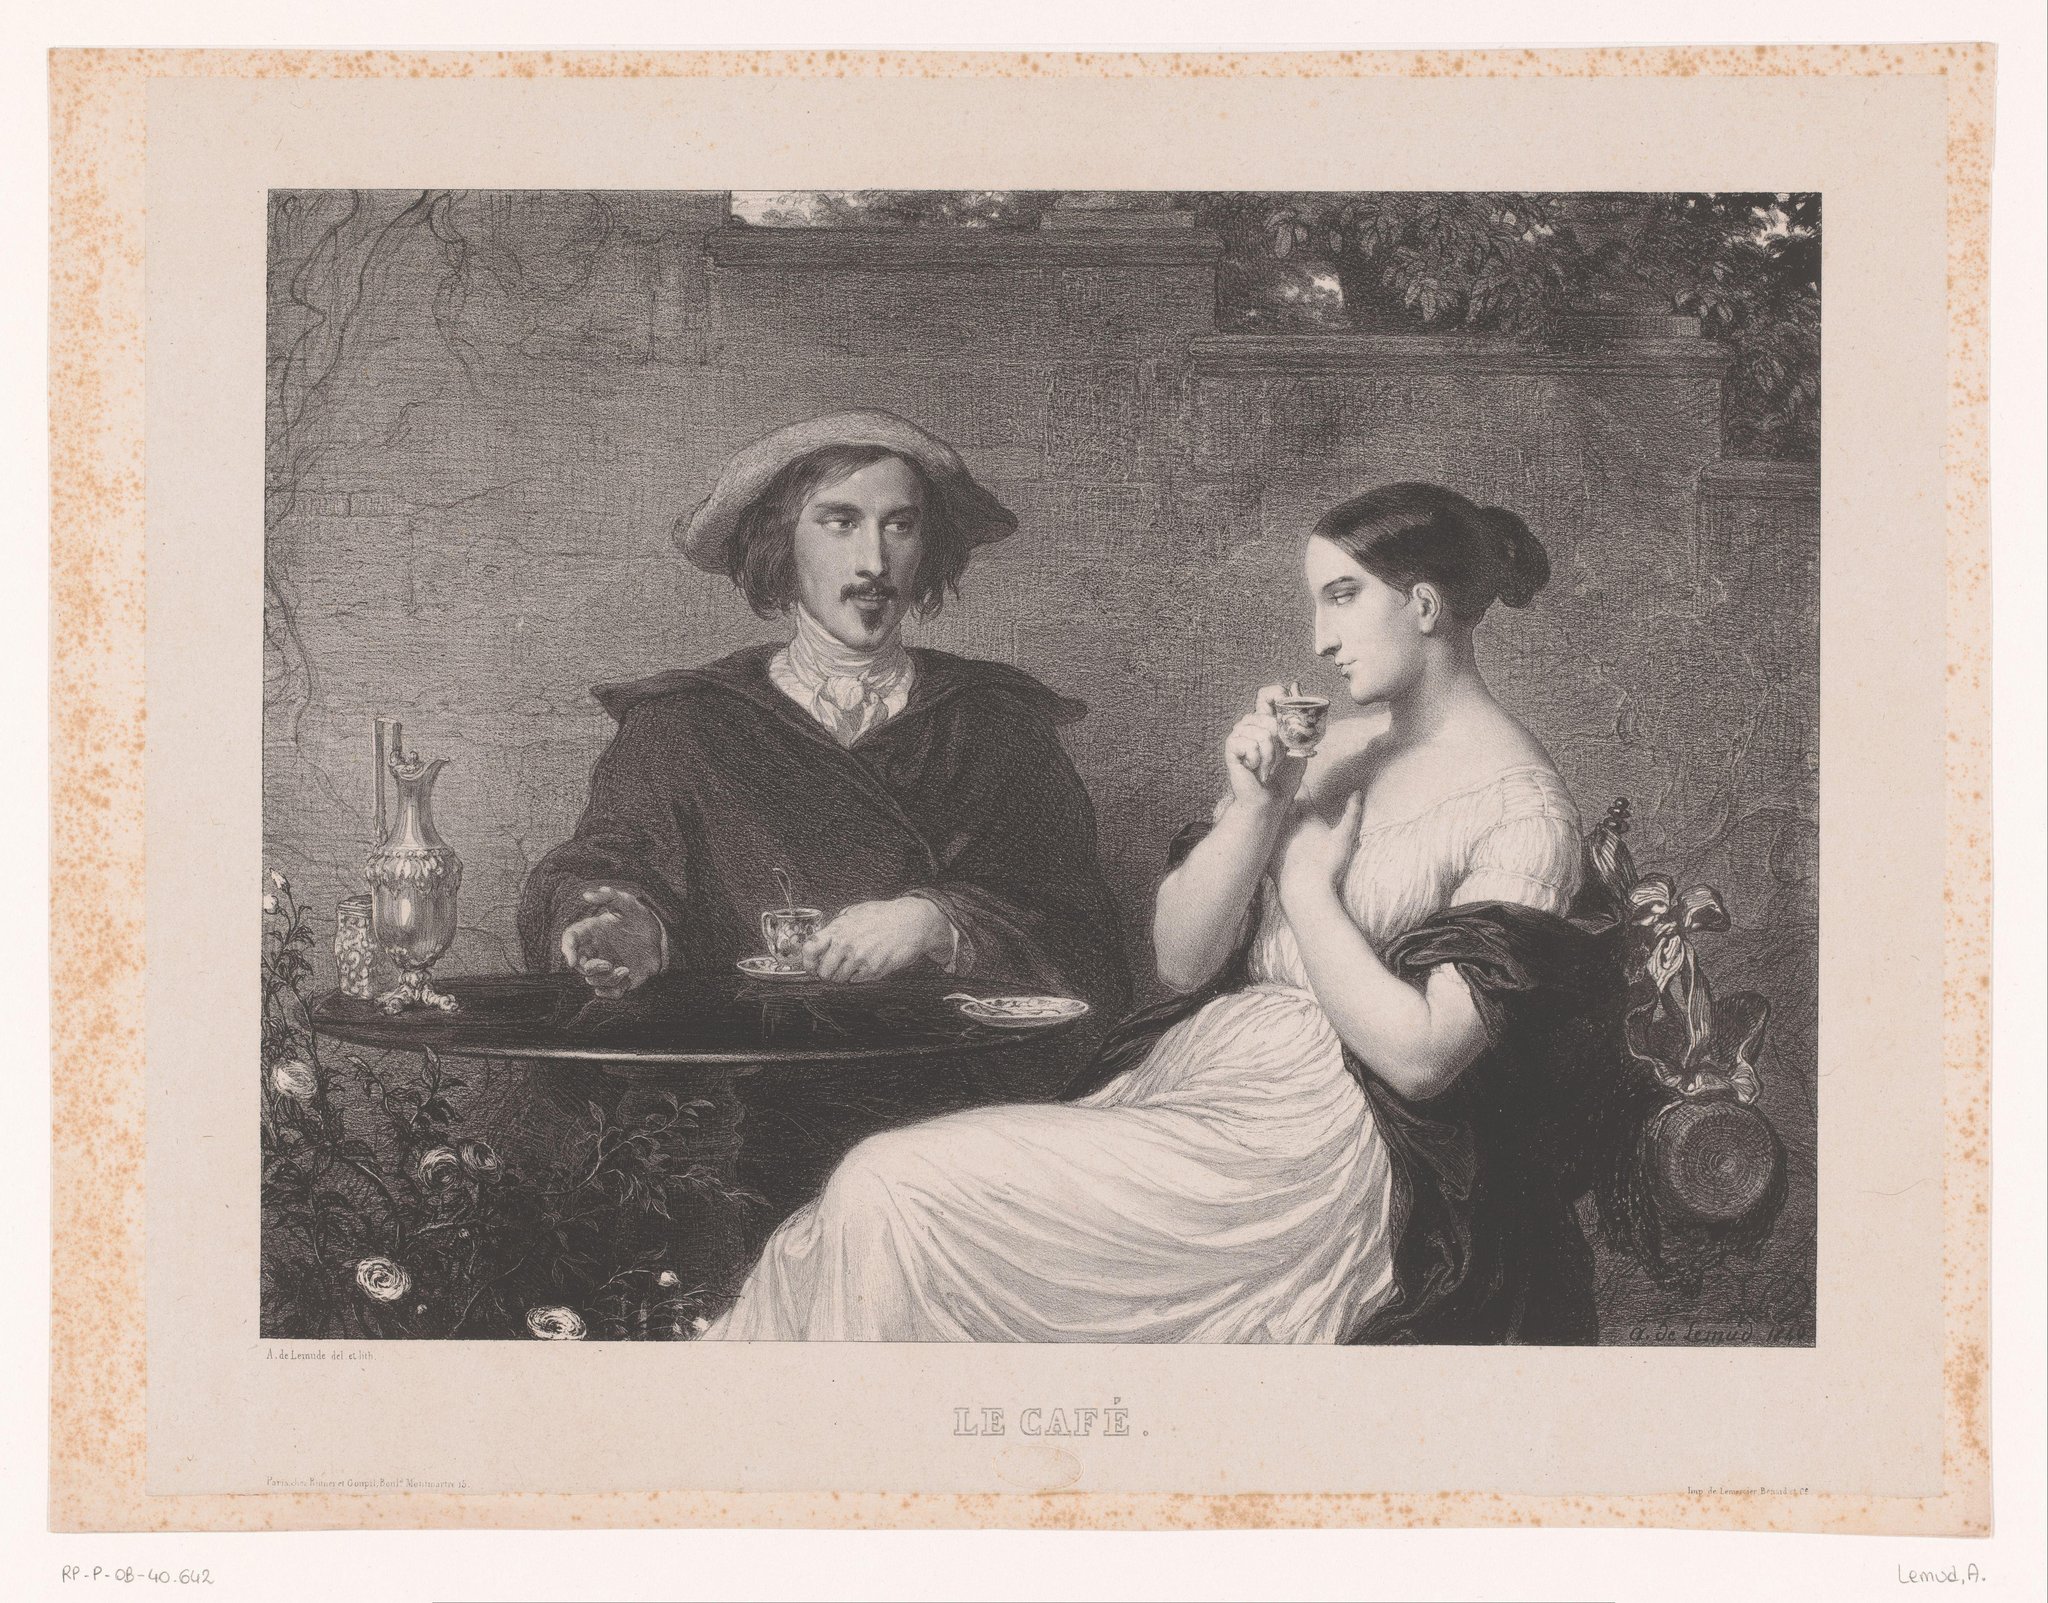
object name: print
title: Man en vrouw drinken koffie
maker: aimé de lemud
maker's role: print maker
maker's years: 1816-1887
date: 1840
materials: paper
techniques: lithography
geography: paris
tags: cup of coffee, drinking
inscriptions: check stamp: Lugt 2140, collector's mark: Lugt 2228a